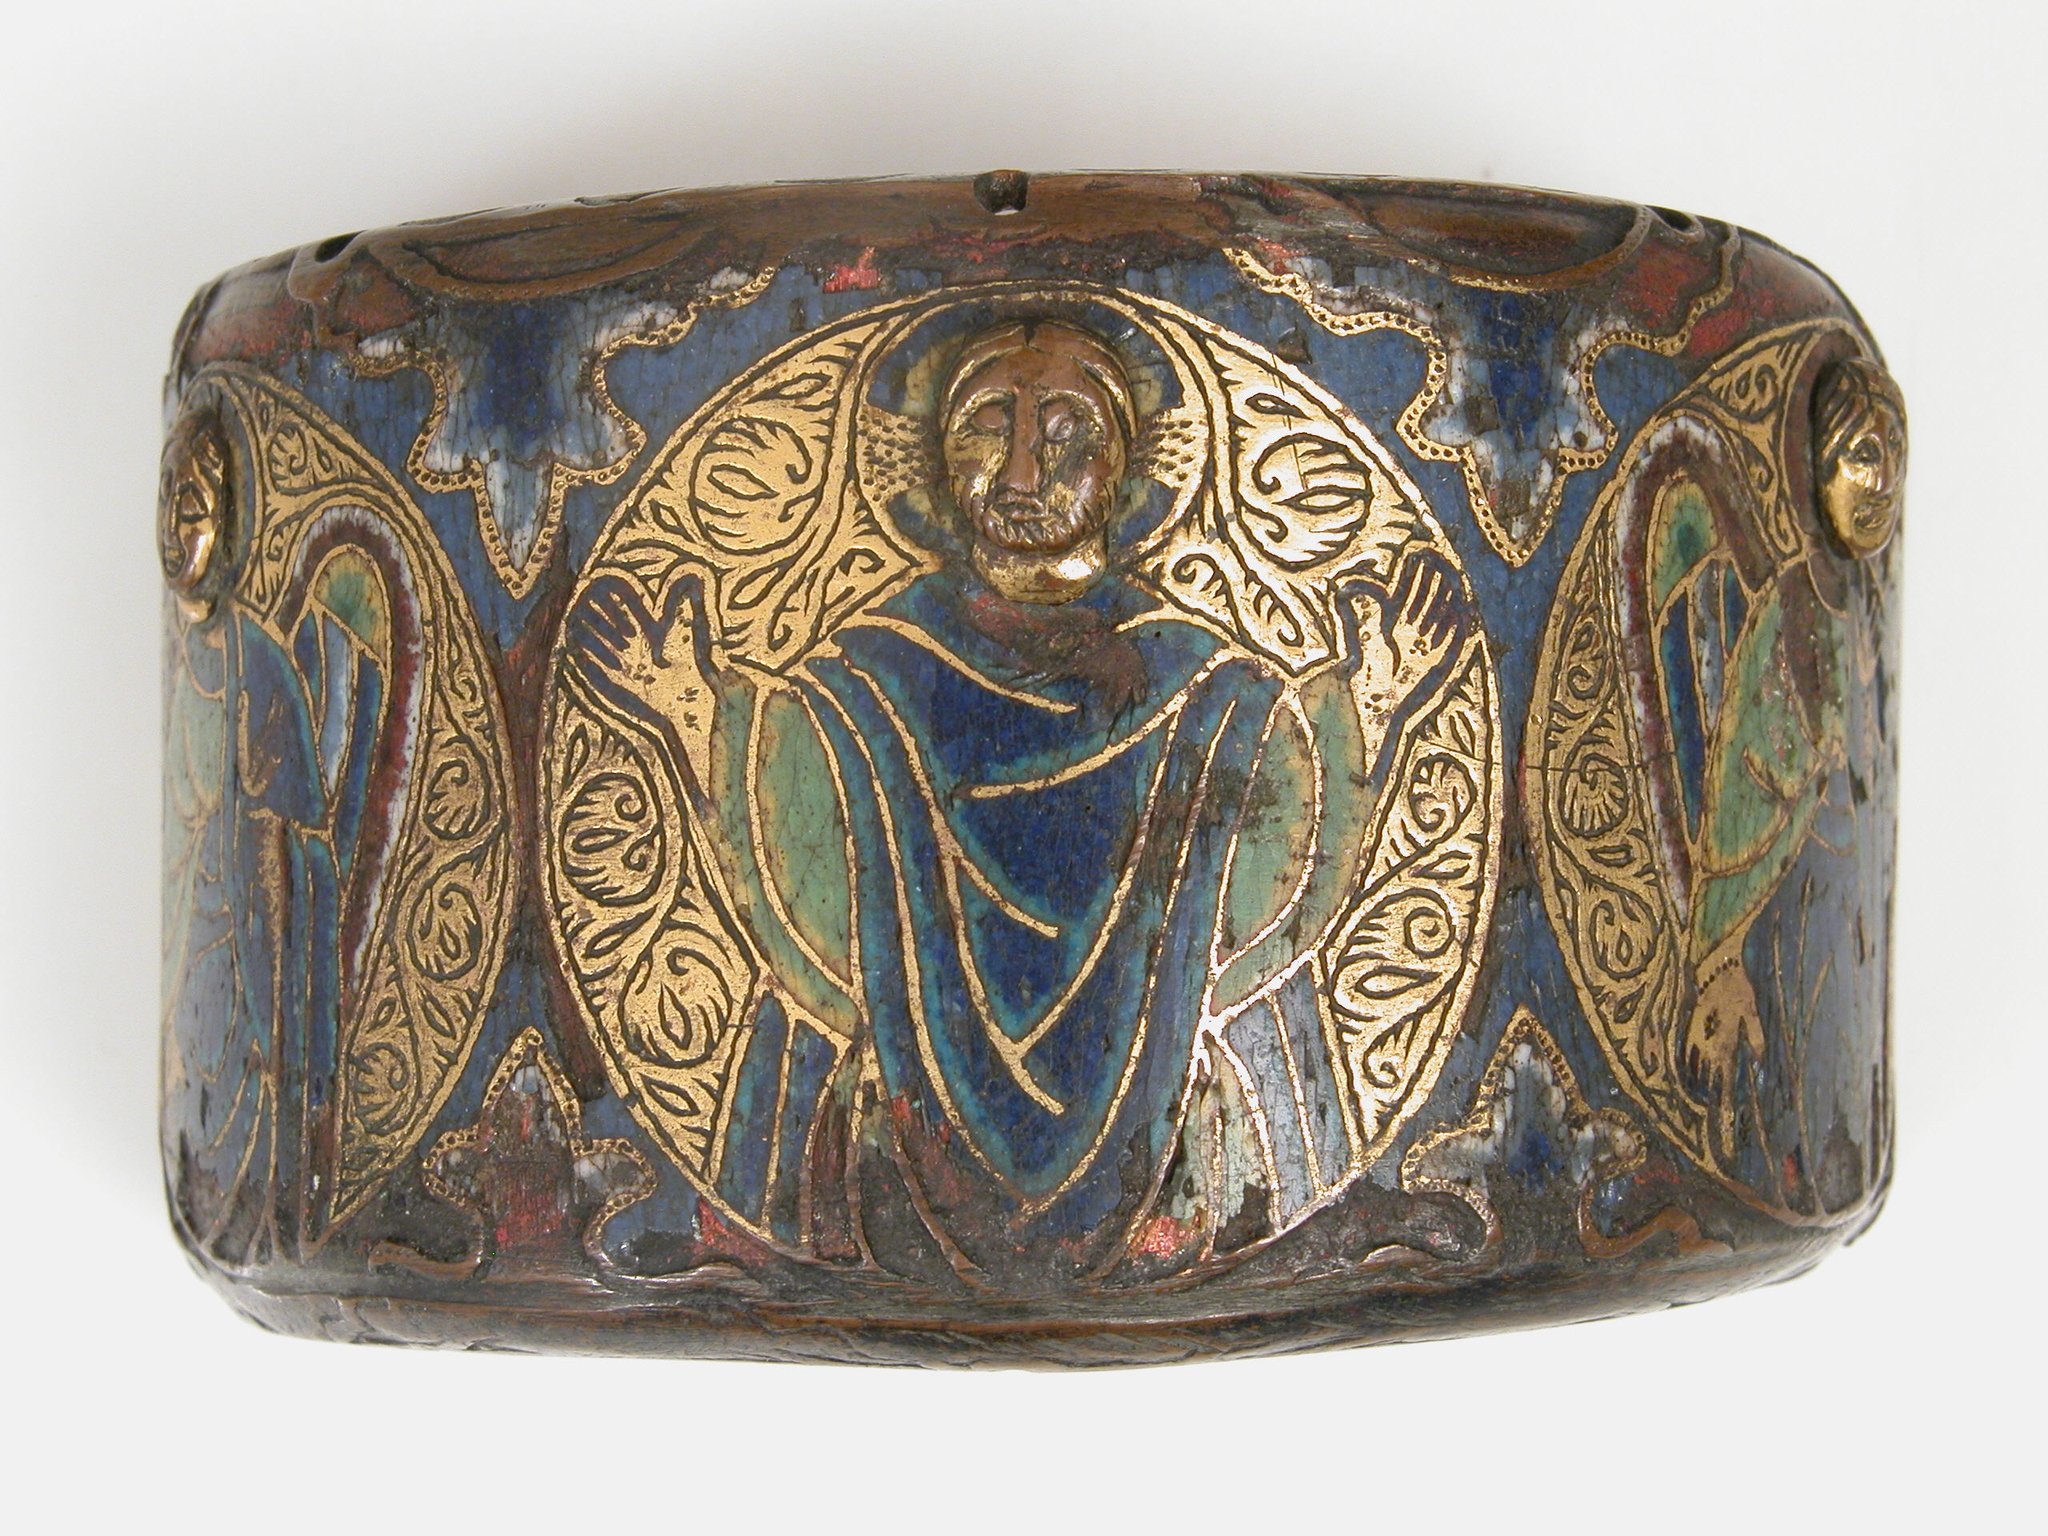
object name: band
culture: french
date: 1201-1233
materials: gilt copper, enamel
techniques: enamel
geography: france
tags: men